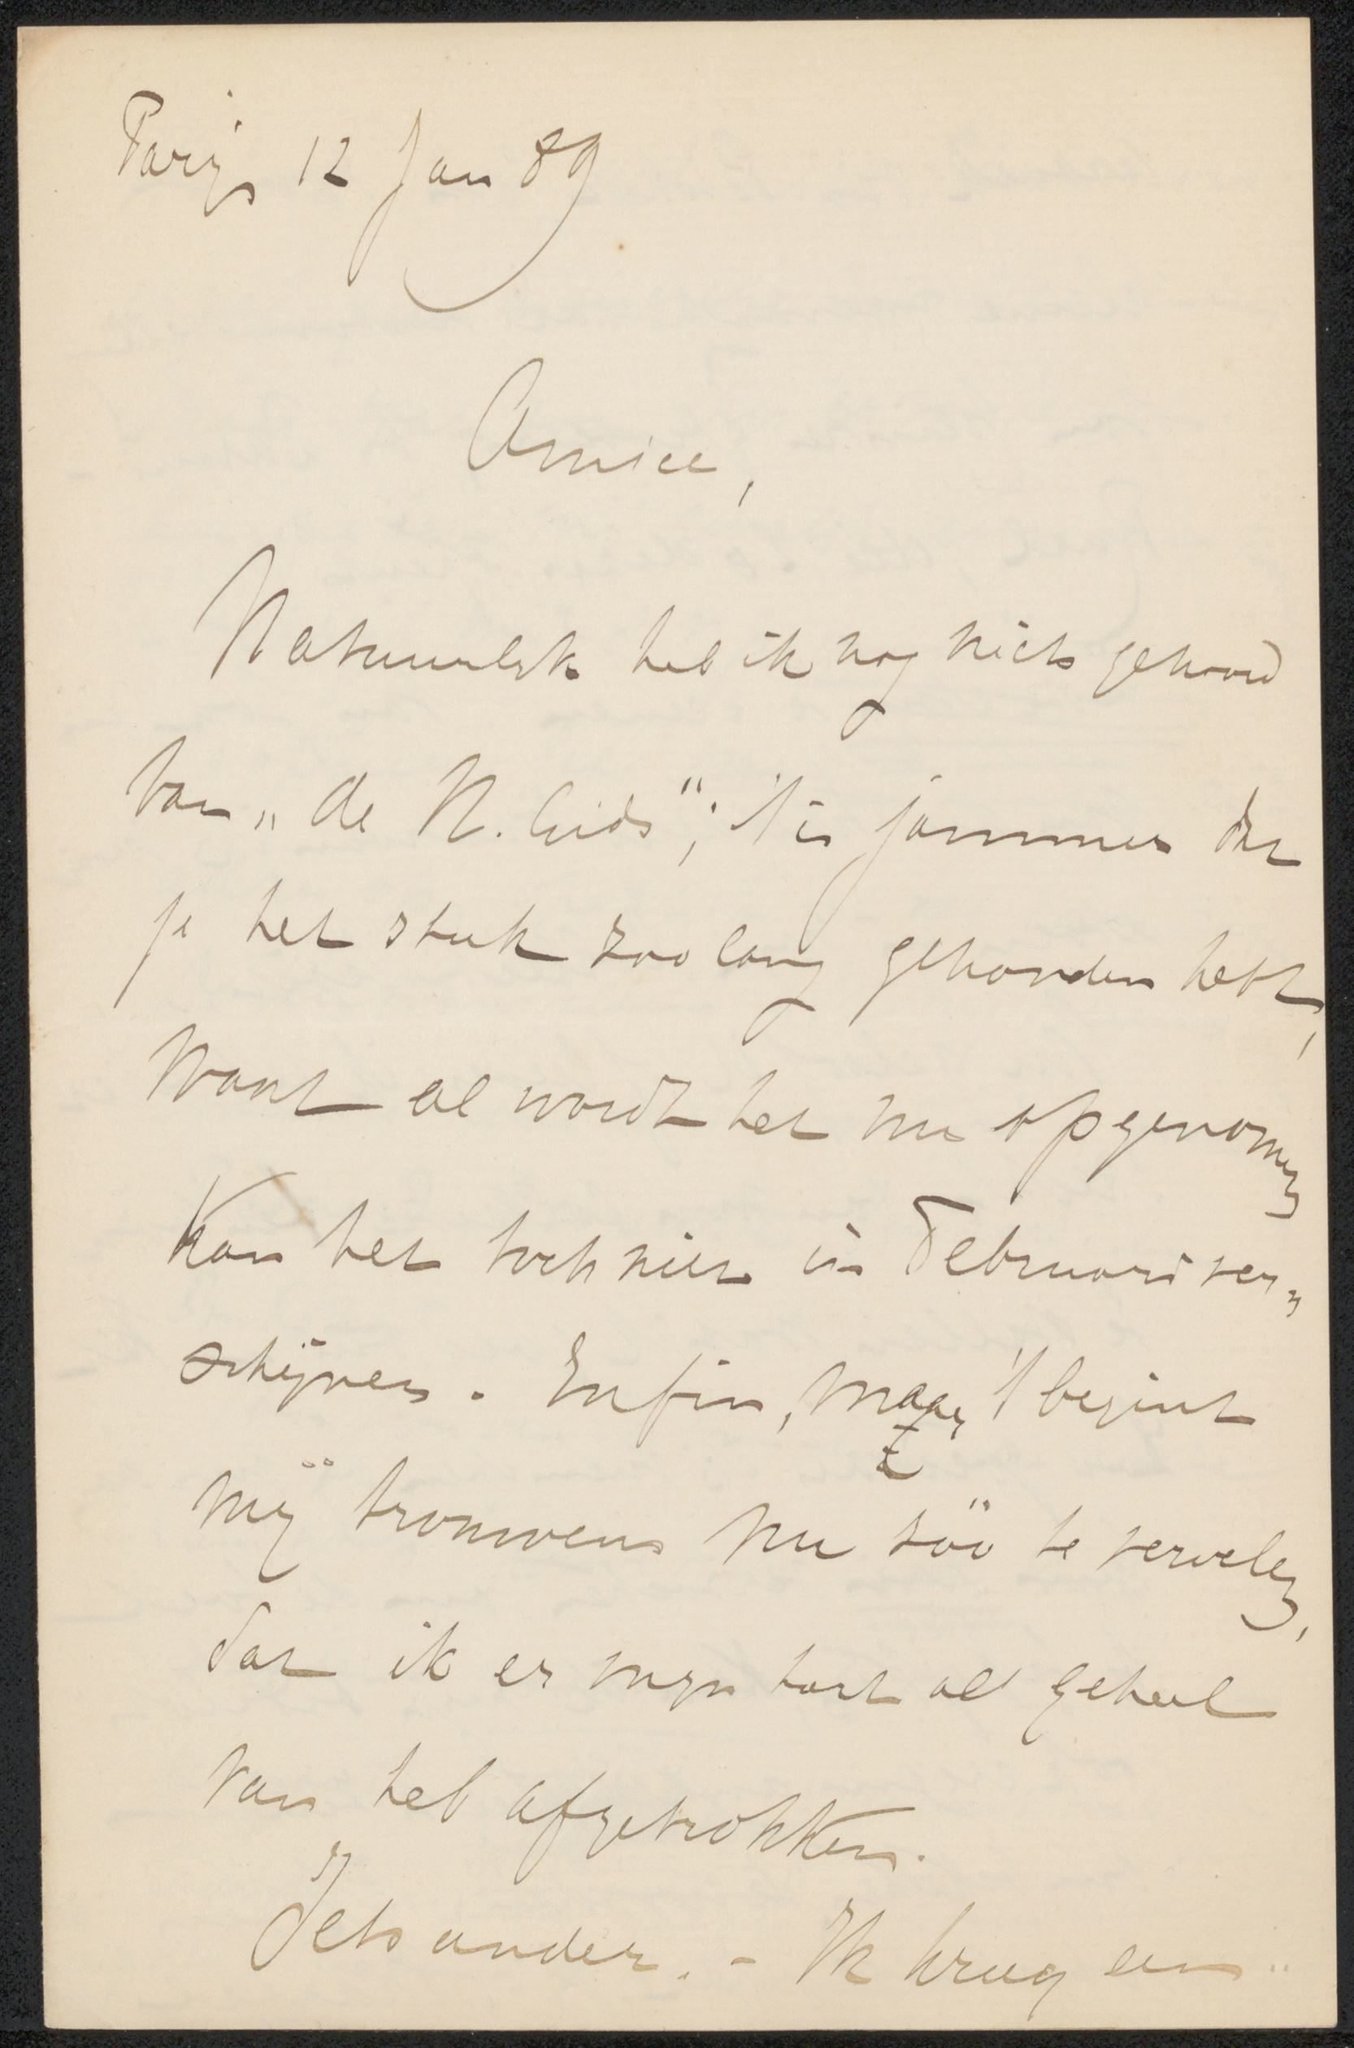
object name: letter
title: Brief aan Philip Zilcken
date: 1889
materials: ink, paper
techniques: pen, writing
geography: paris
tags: bernardus johannes blommers, dordrecht, designer, jan veth, london, matthijs maris, marinus van der maarel, amsterdam, willem witsen, willem de zwart, paris, print maker, draughtsman, félix hilaire buhot, painter, philip zilcken, landscapes, the graphic arts, exhibition ~ art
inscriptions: collector's mark: ‘RPK’